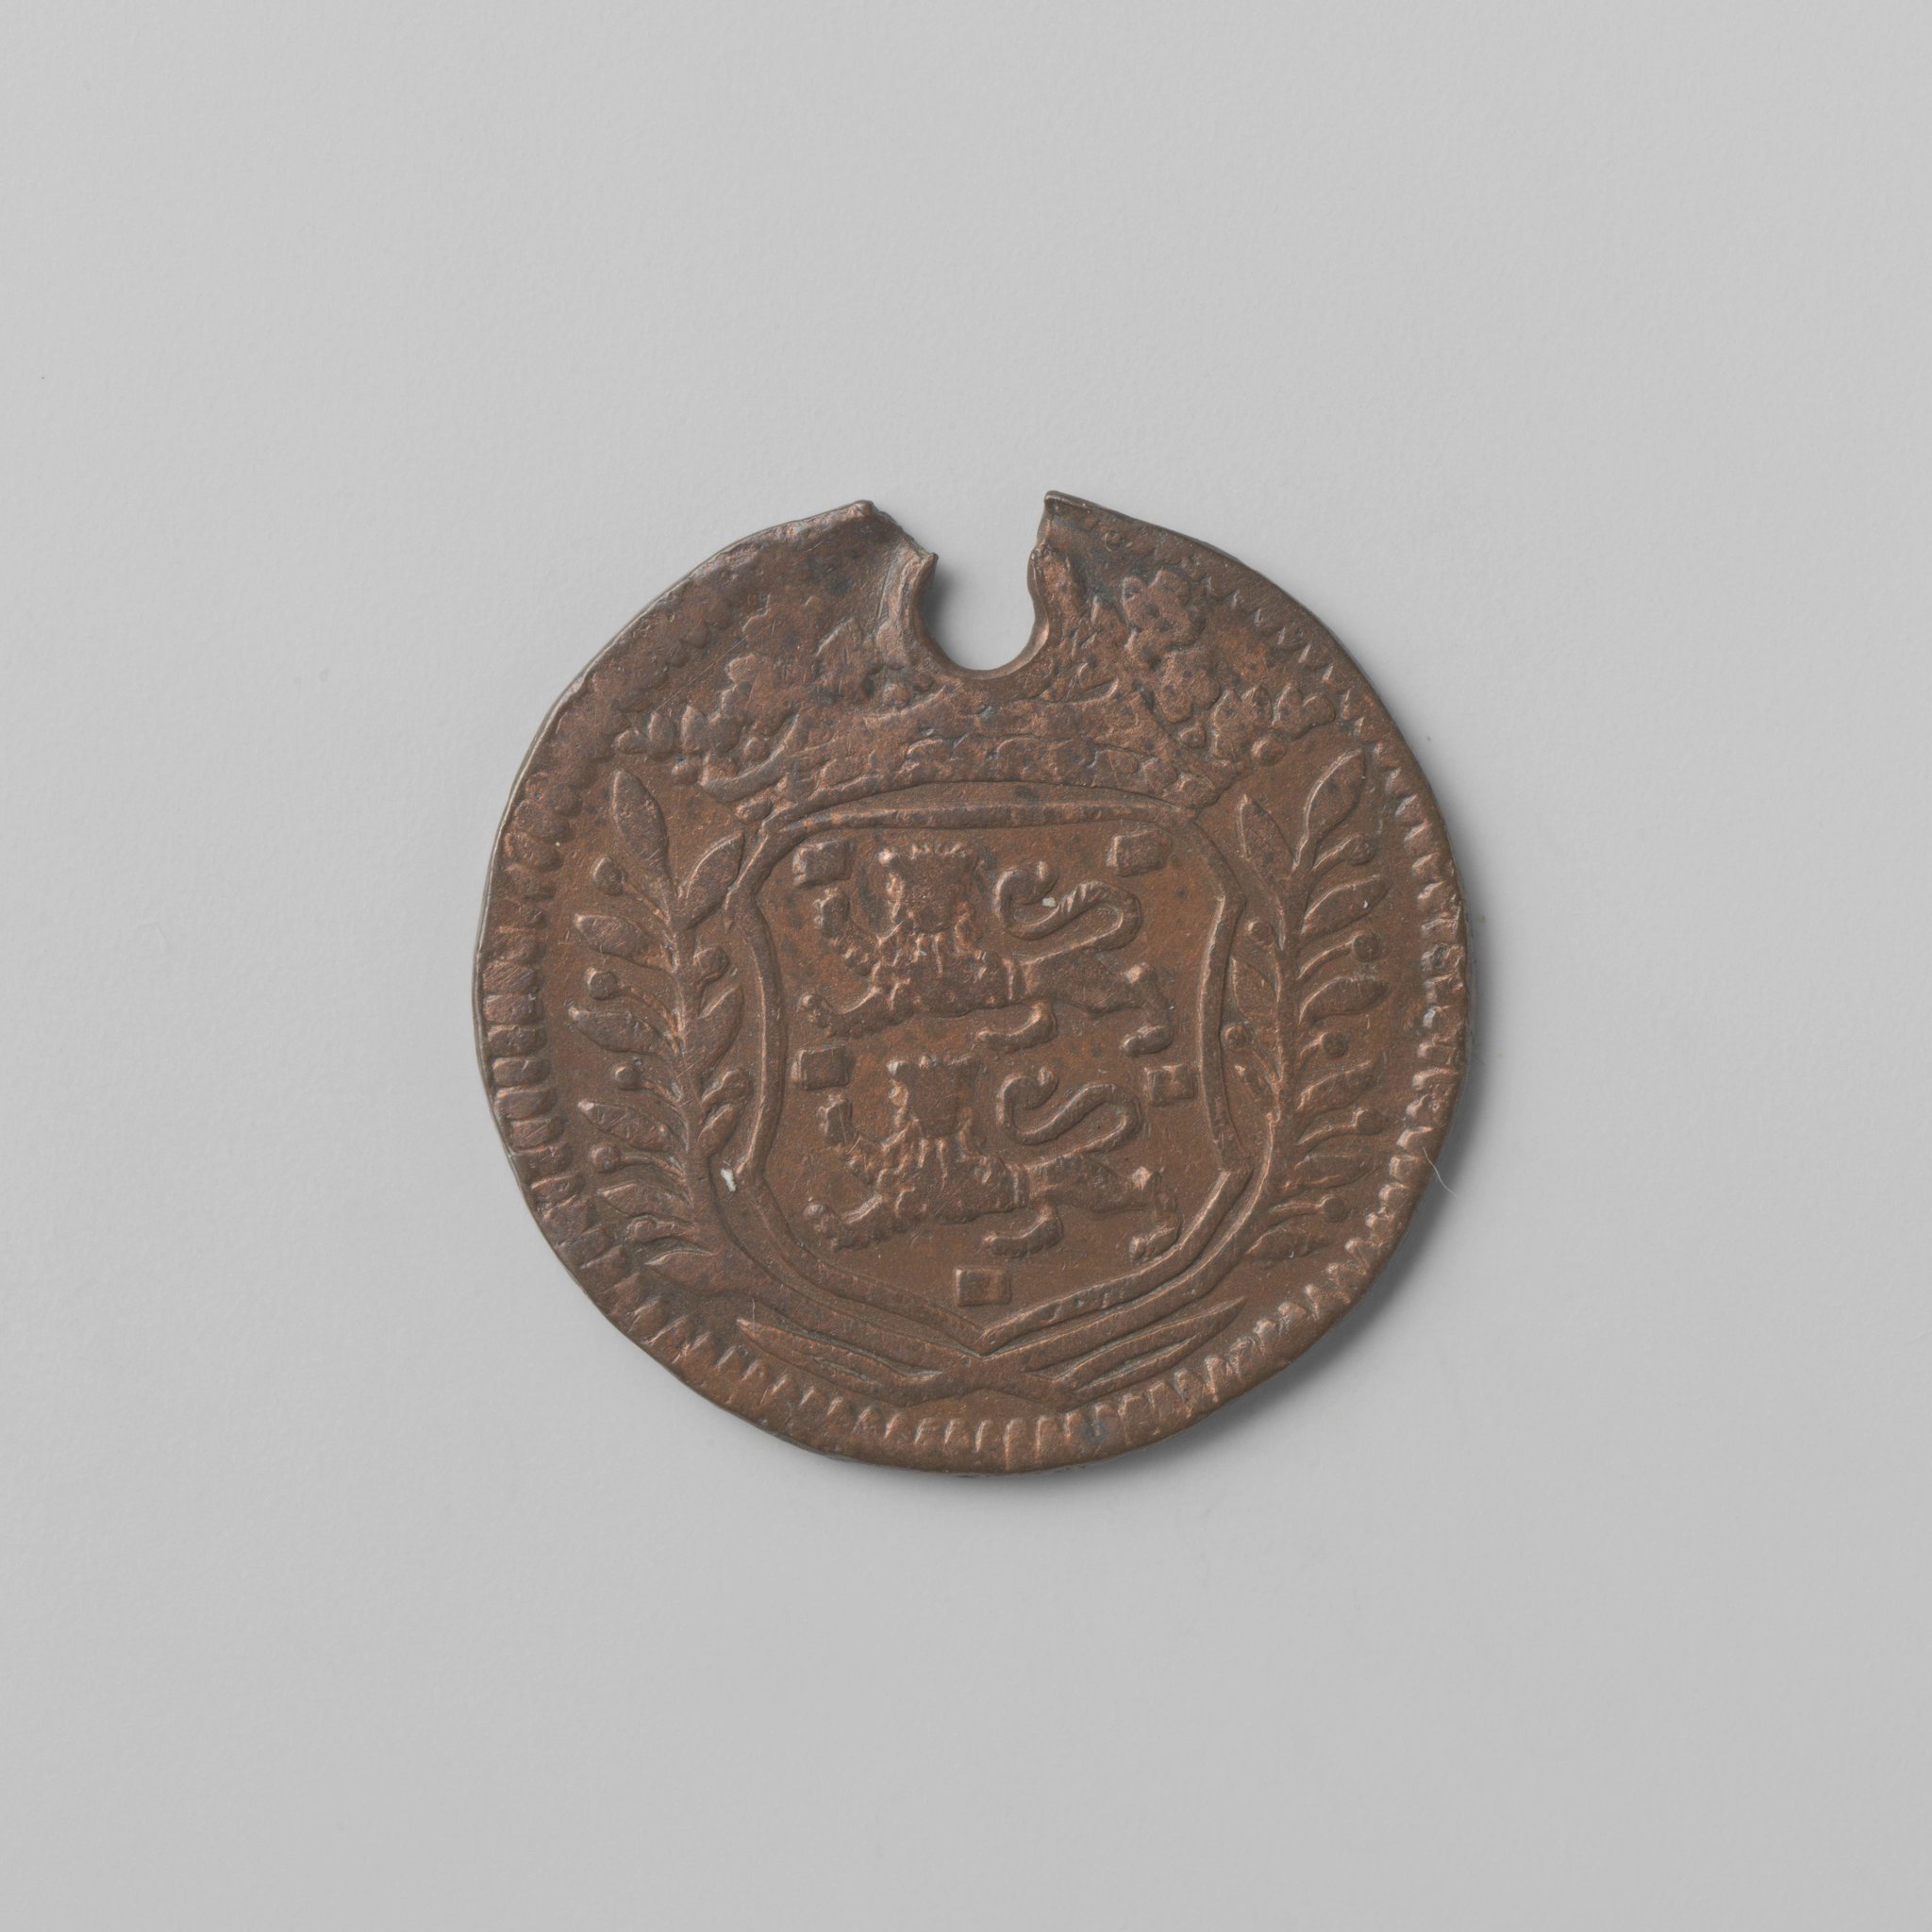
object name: coin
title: Westfriese duit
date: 1740-1760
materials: copper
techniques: striking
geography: west frisia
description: Koperen munt. Voorzijde: gekroond wapenschild van West-Friesland met lauwertakken. Keerzijde: eveneens gekroond wapenschild van West-Friesland met lauwertakken. Tweemaal voorzijde-stempel.